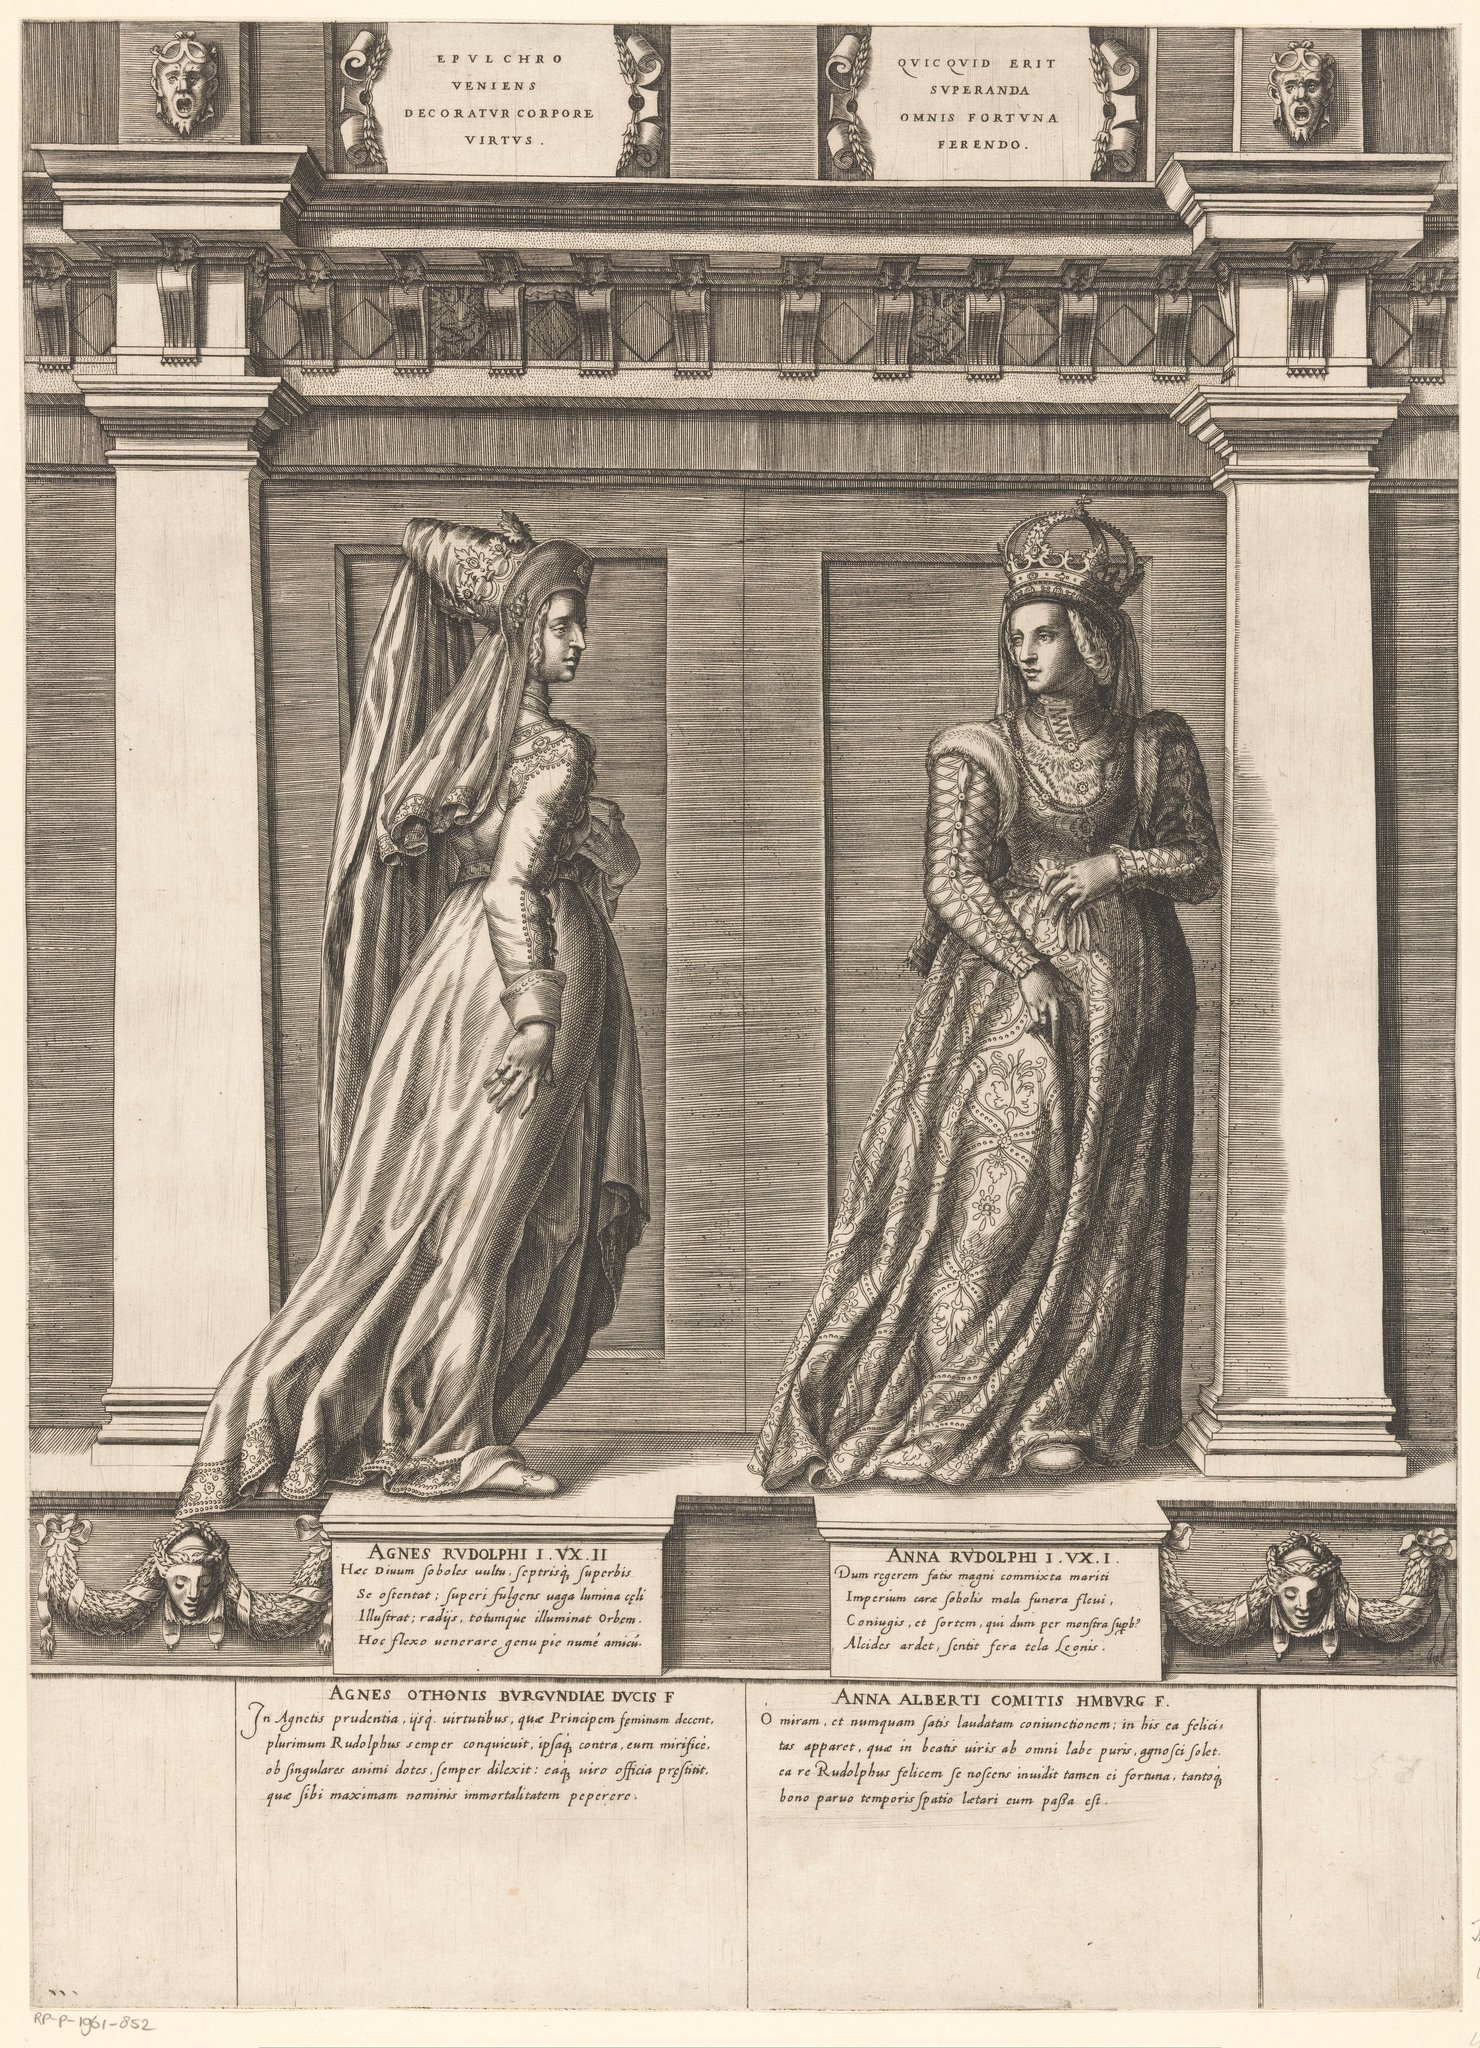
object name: print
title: Portretten van leden van het Oostenrijkse Huis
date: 1569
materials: paper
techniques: engraving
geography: italy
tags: historical persons - bb - woman, ruler, sovereign - bb - female ruler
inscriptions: collector's mark: Lugt 2228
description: Deze prent maakt deel uit van een reeks van 58 prenten. Het meerendeel van de prenten bevat portretten van 74 leden van het Oostenrijkse Huis, naar tekeningen door Francesco Terzio, die deels getekend zijn naar de 28 levensgrote bronzen beelden die rond de cenotaaf van Maximiliaan I in de Hofkirche te Innsbruck staan.